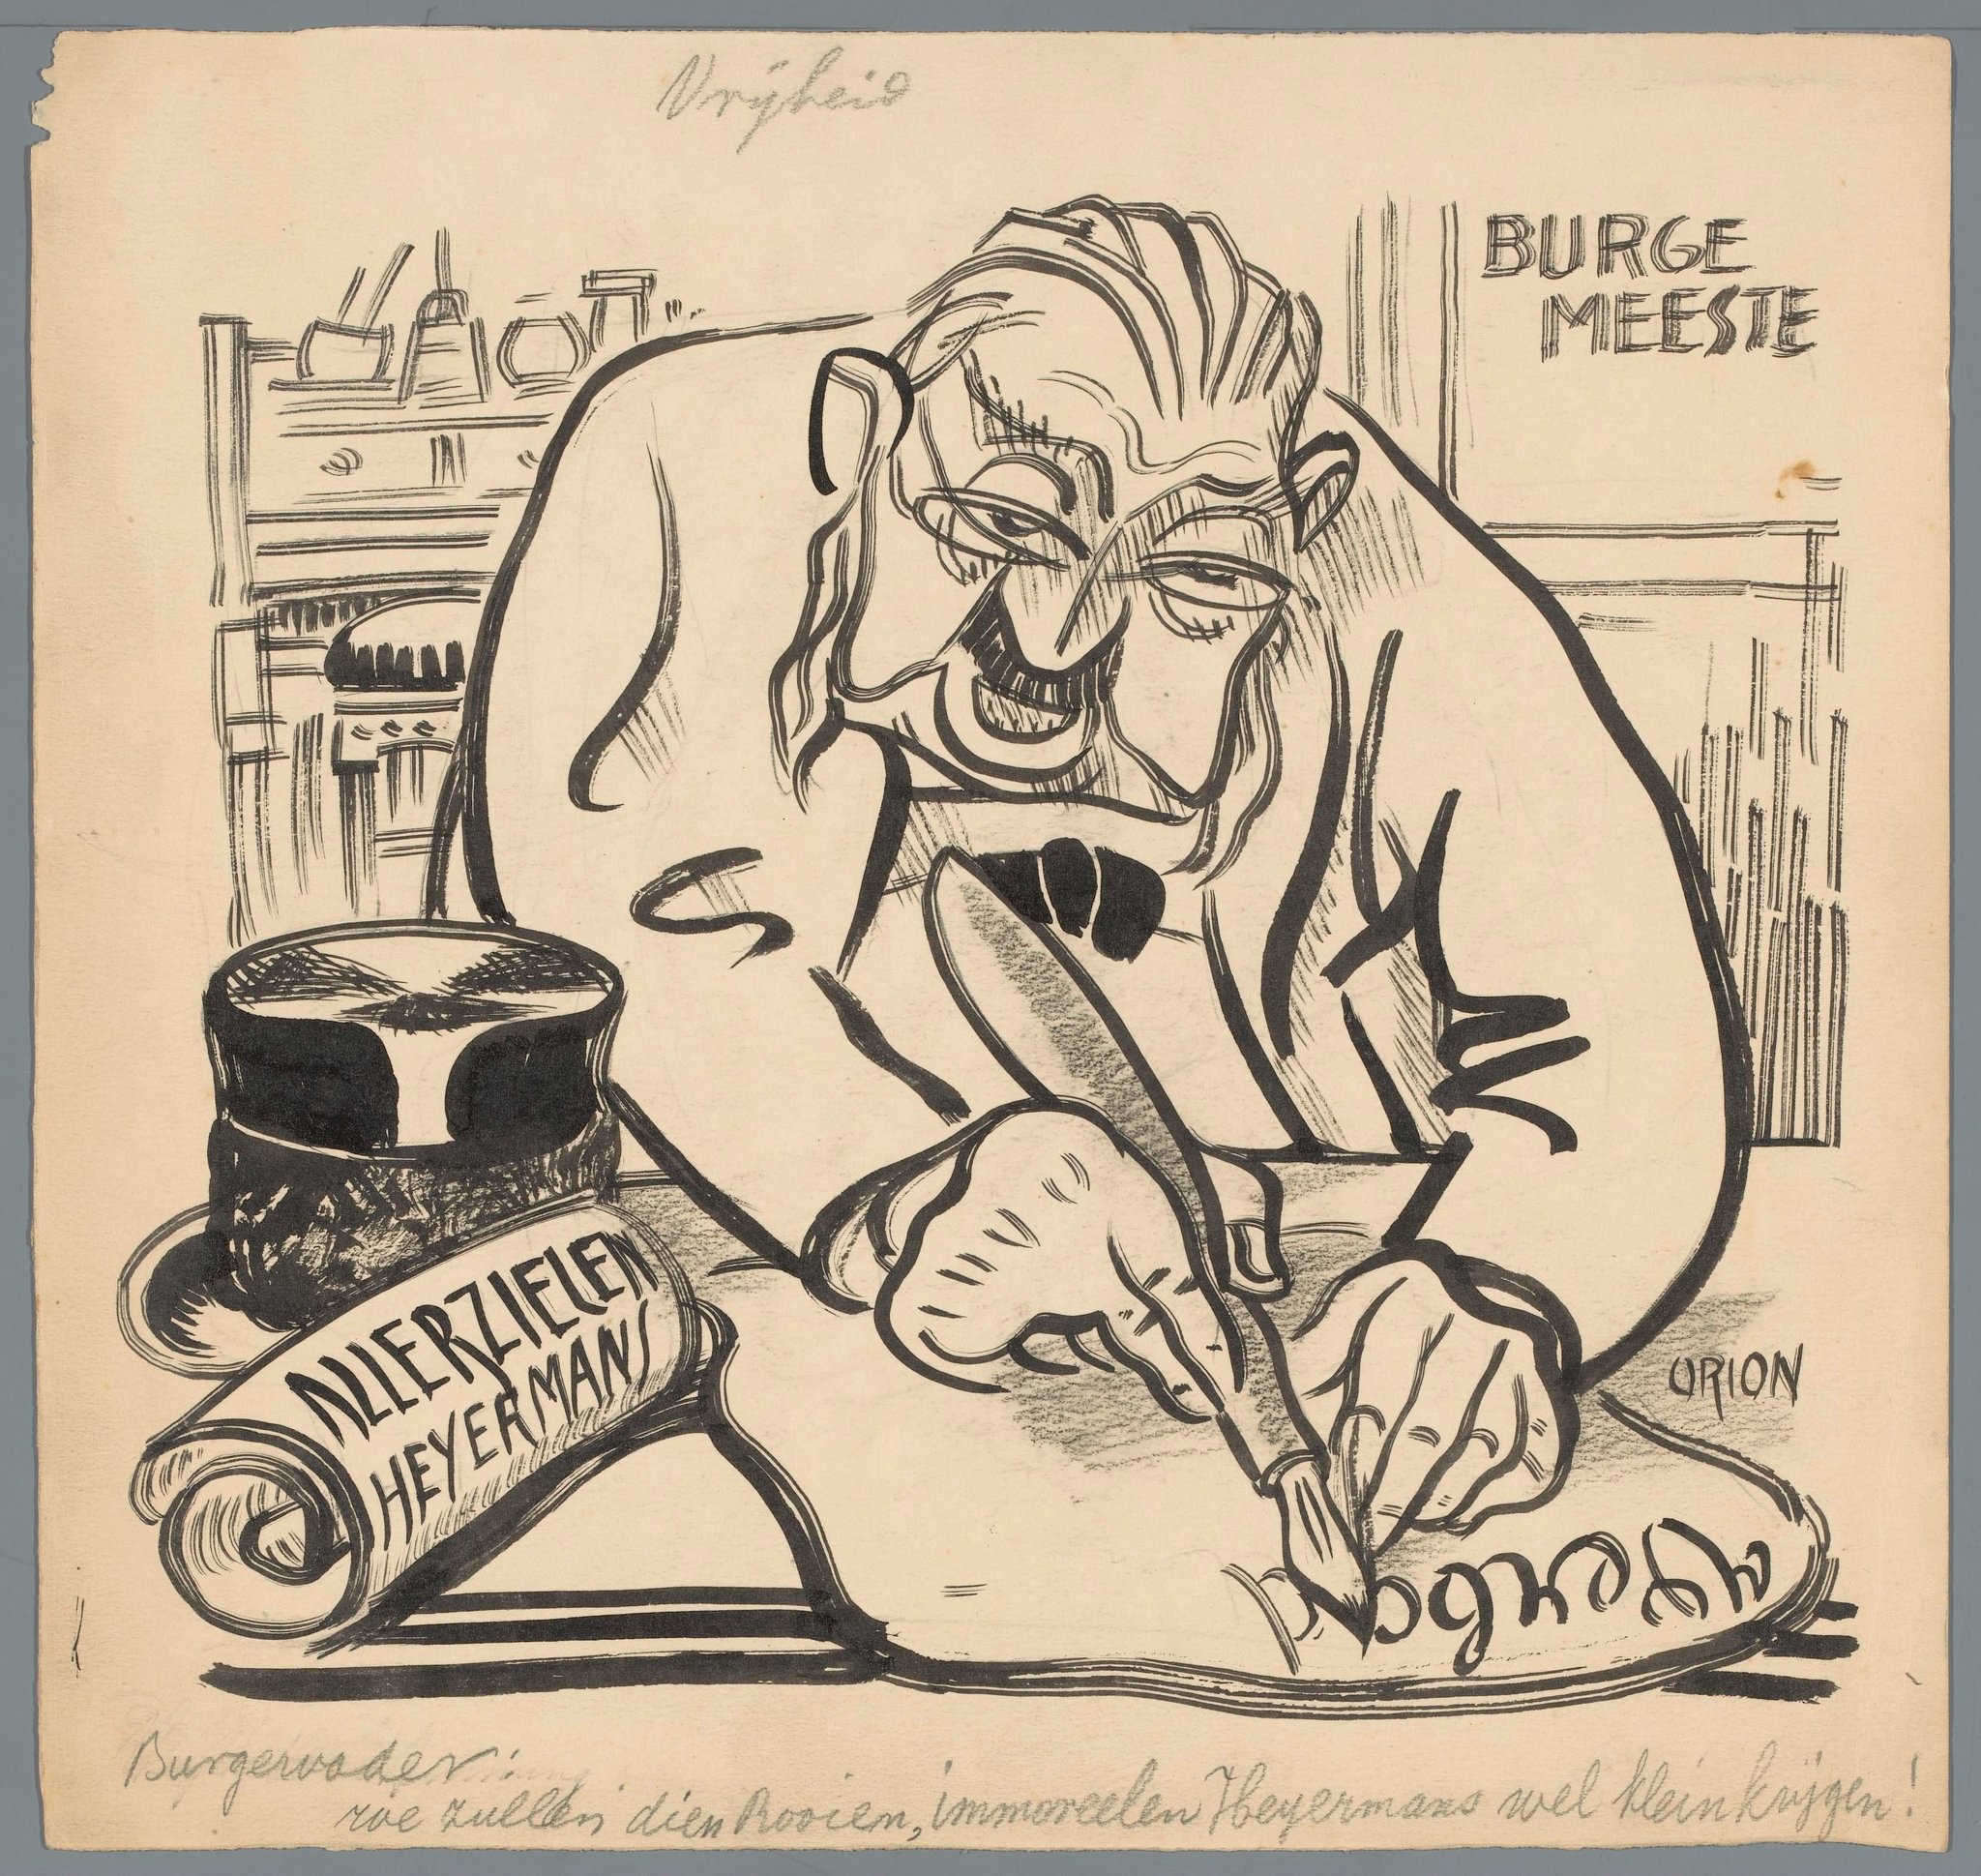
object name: drawing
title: Burgemeester verbiedt Heijermans Allerzielen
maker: patricq kroon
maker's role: draughtsman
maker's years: 1862-1941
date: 1904-1905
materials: chalk, ink, paper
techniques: pen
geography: netherlands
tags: herman heijermans, theatre, theatrical performance, mayor, burgomaster, political caricatures and satires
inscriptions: inscription: ‘Vrijheid / Bugervader: we zullen dien Rooien, immoreelen Heyermans wel klein krijgen!’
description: Een burgemeester schrijft een verbod uit op de opvoering van Heijermans toneelstuk Allerzielen (1904). Ontwerp voor een politieke spotprent.